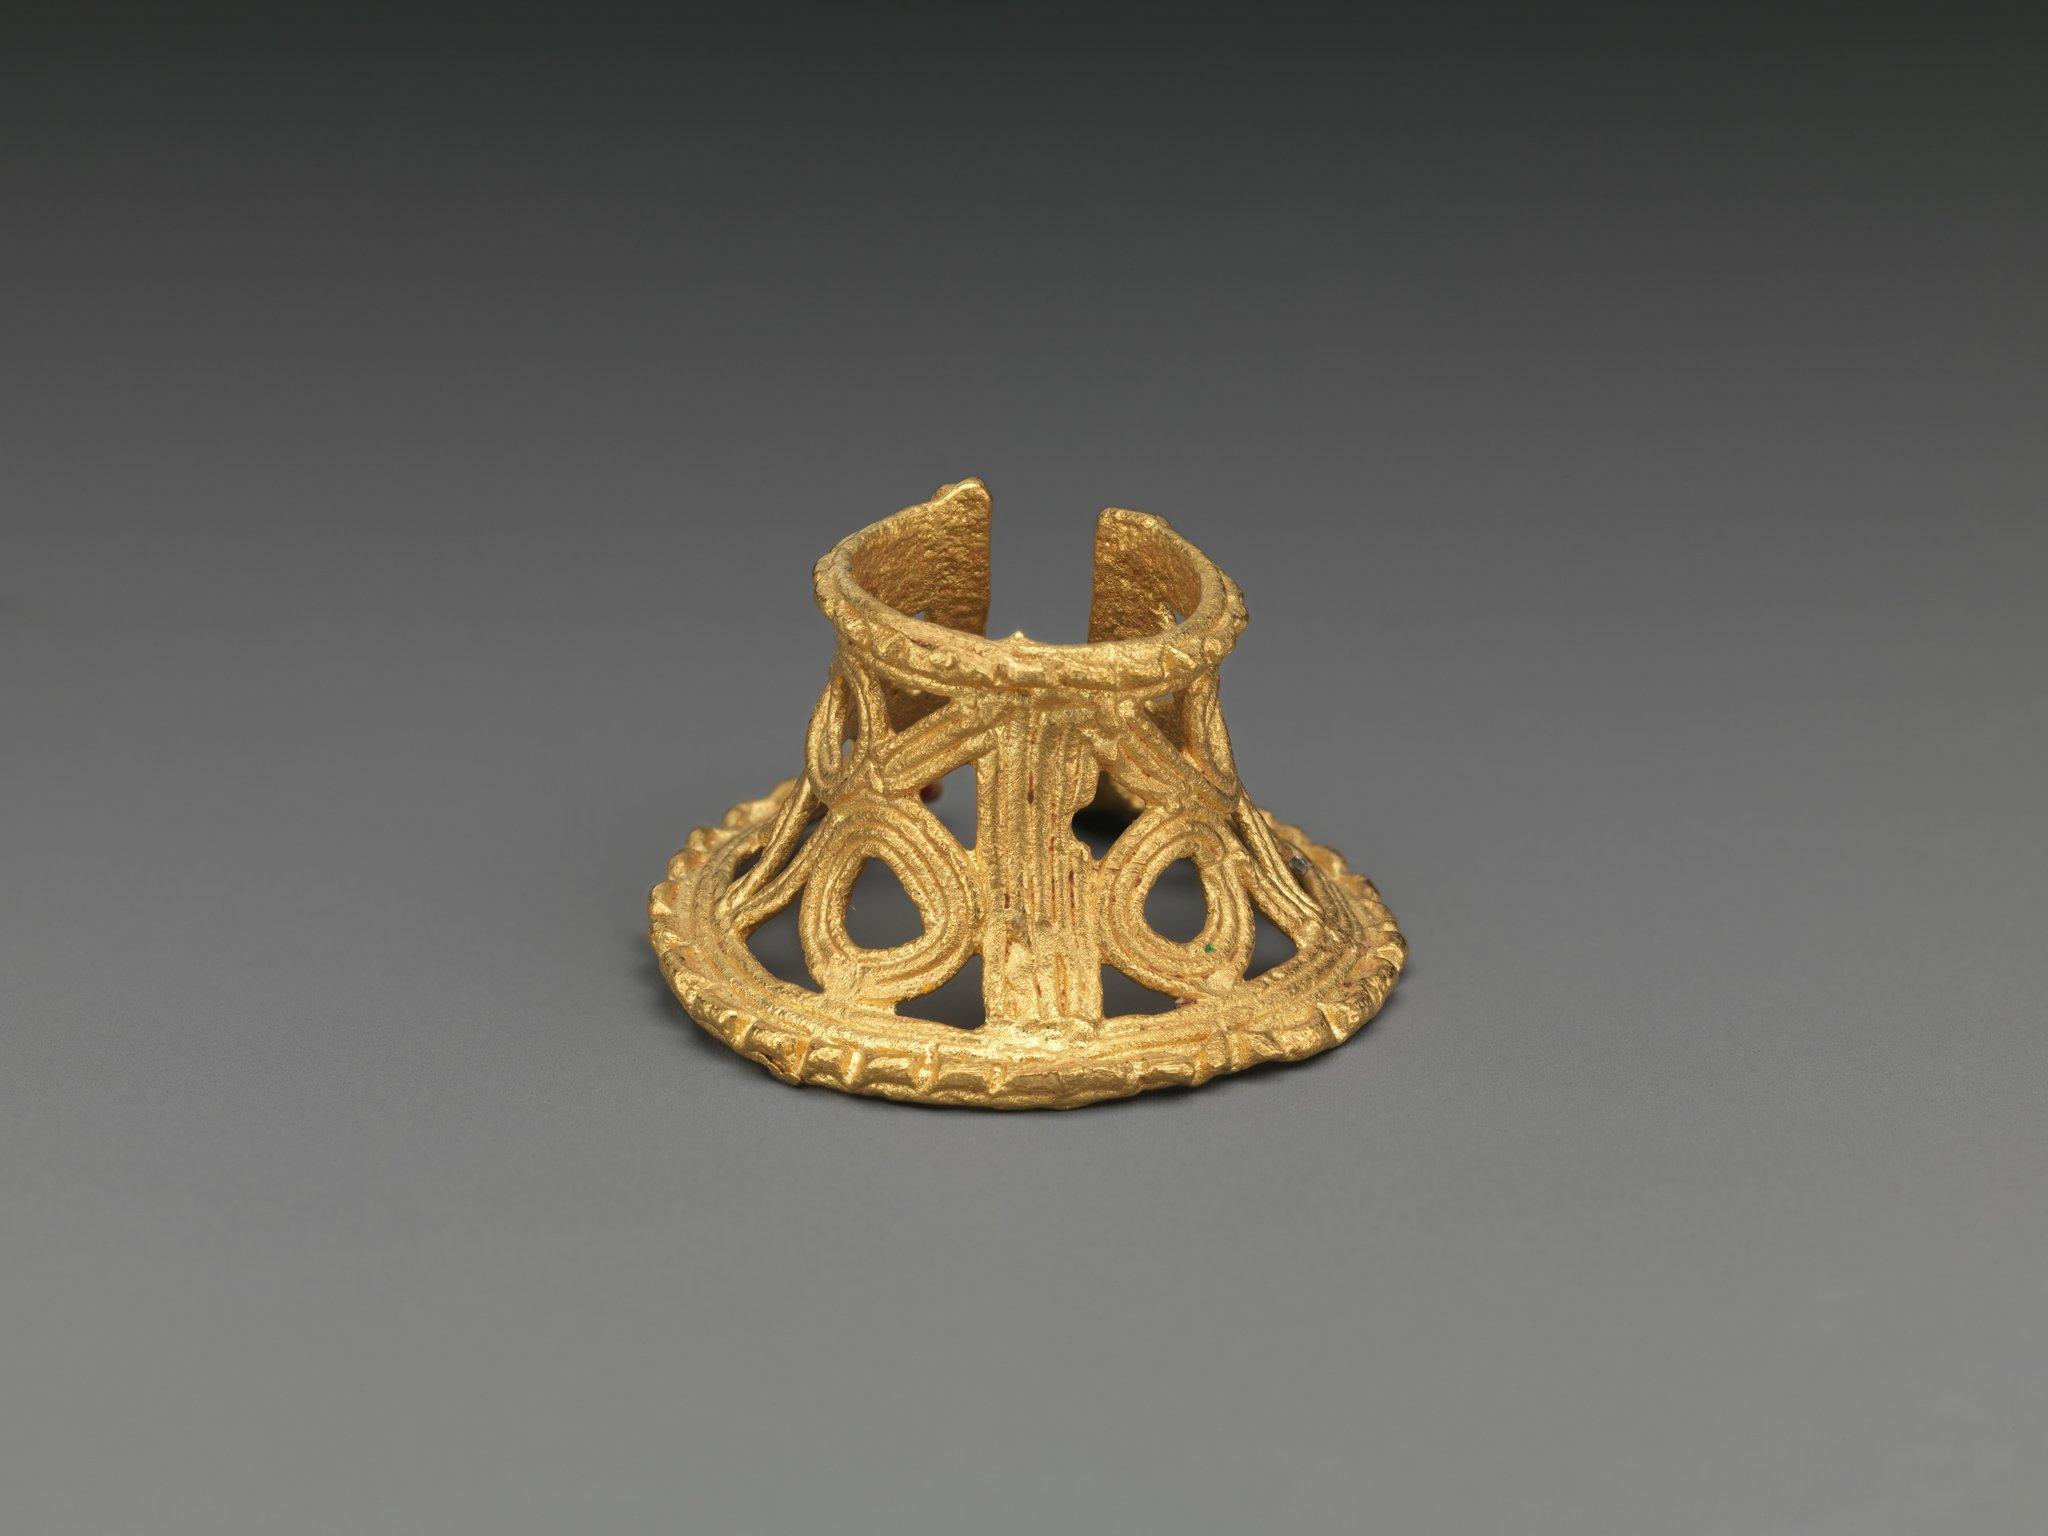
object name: nose ornament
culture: venado beach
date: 401-800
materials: gold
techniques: casting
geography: panama